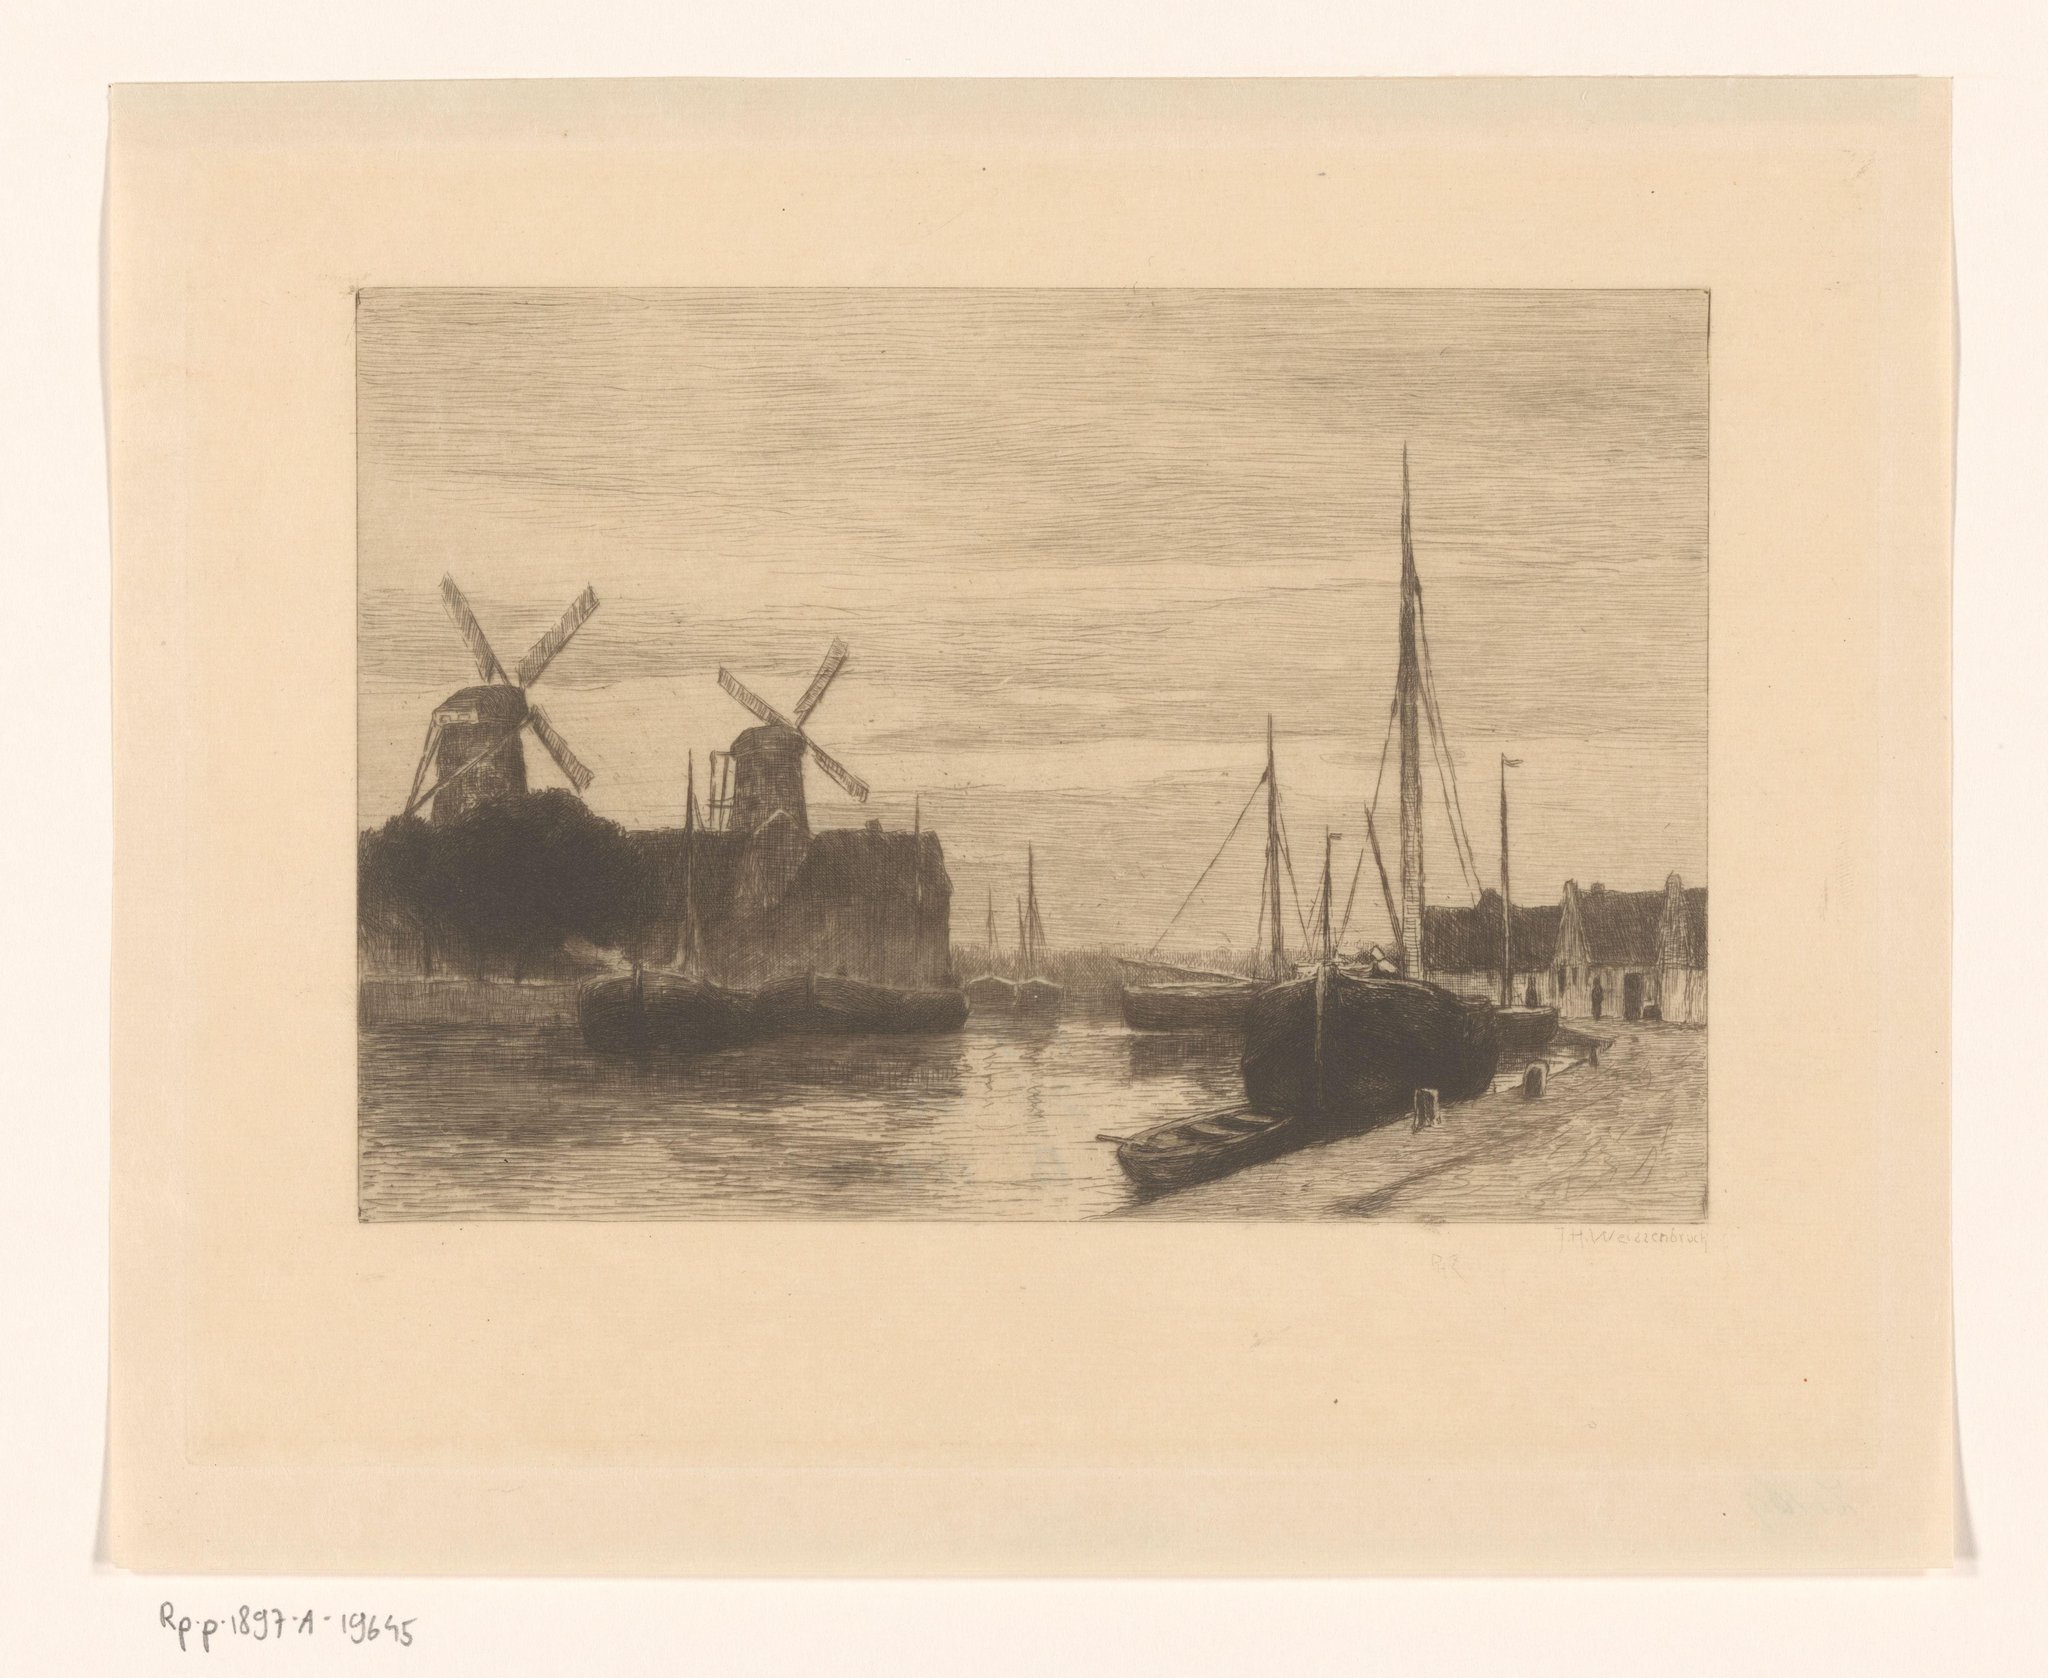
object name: print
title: Aan 't Spaarne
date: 1867-1890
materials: paper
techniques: drypoint, etching, intaglio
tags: river, windmill, haarlem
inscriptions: collector's mark: Lugt 2228